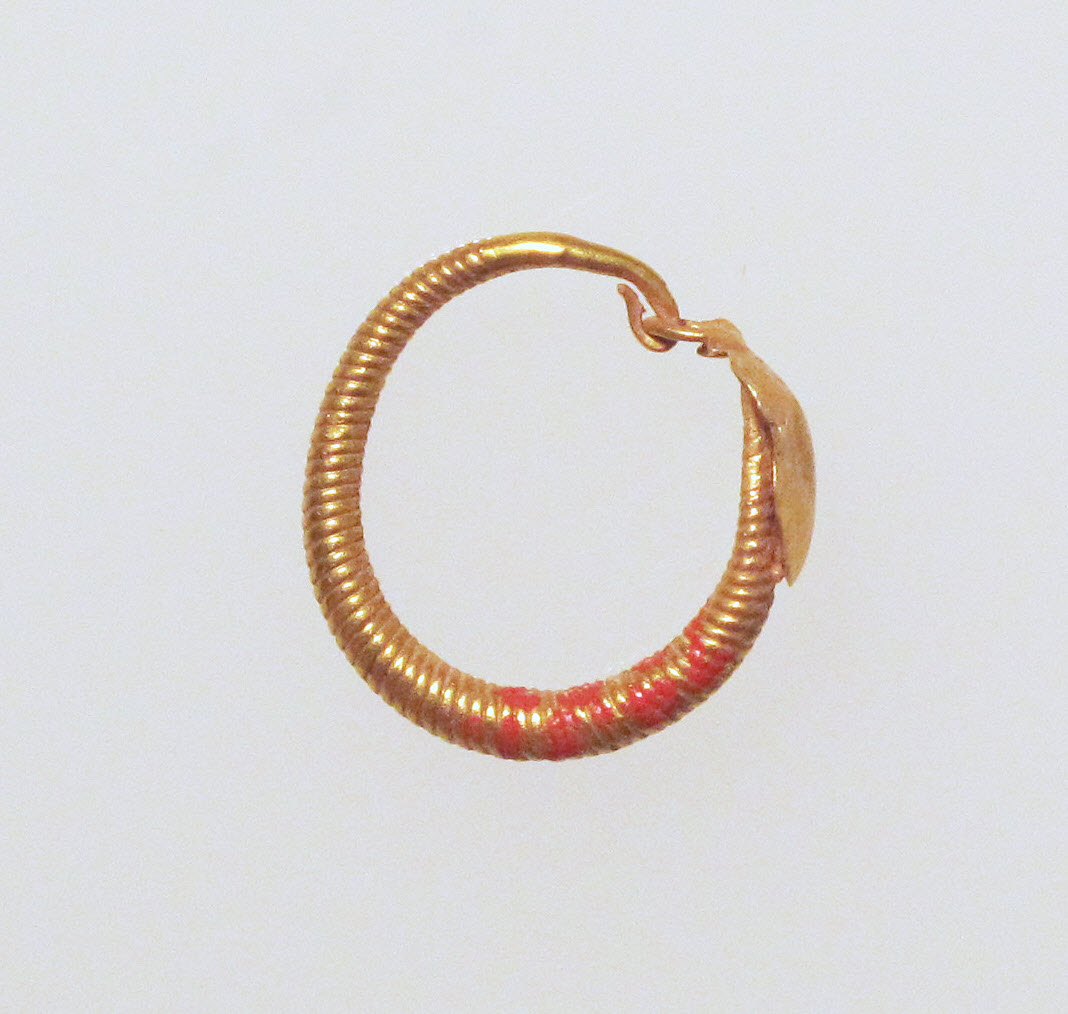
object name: earring with plain loop and disc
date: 7000 BCE-330 CE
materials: gold